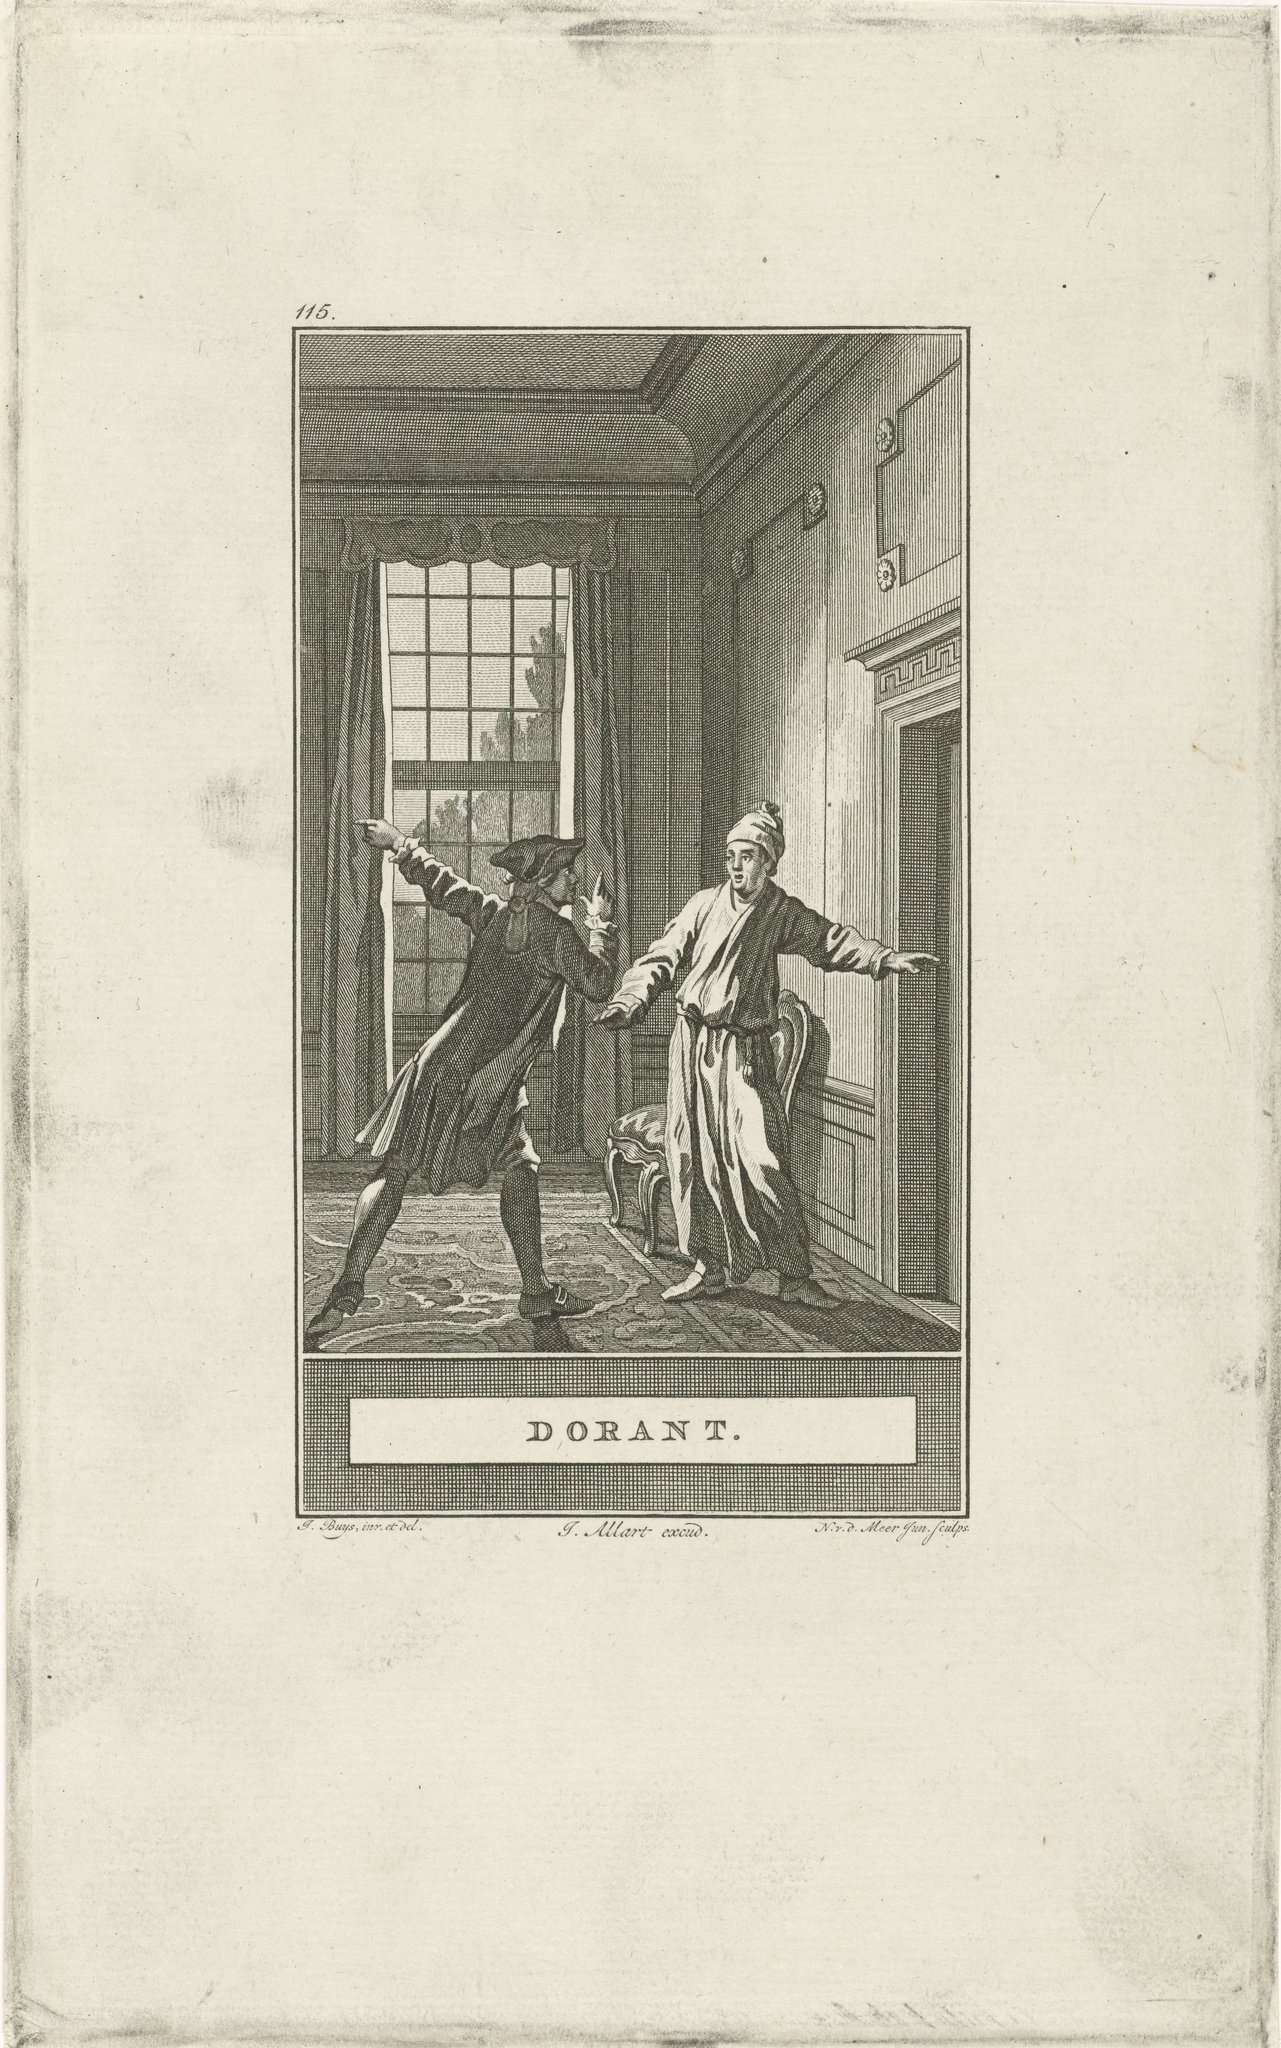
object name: print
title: Dorant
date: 1778-1785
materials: paper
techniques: etching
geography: amsterdam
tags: alarm, fright; 'spavento', 'terrore' (ripa), nightwear: night-gown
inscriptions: collector's mark: Lugt 2228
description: Prent bij: Gellert, Christian Fürchtegott. Fabelen en vertelsels. 3 dln. Amsterdam: Pieter Meyer, 1772-1774. De prenten bij deze publicatie werden later uitgegeven. De exemplaren uitgegeven door de weduwe Jacobus Loveringh & Johannes Allart tussen 1777 en 1778, de exemplaren uitgegeven door alleen Johannes Allart tussen 1778 en 1785.